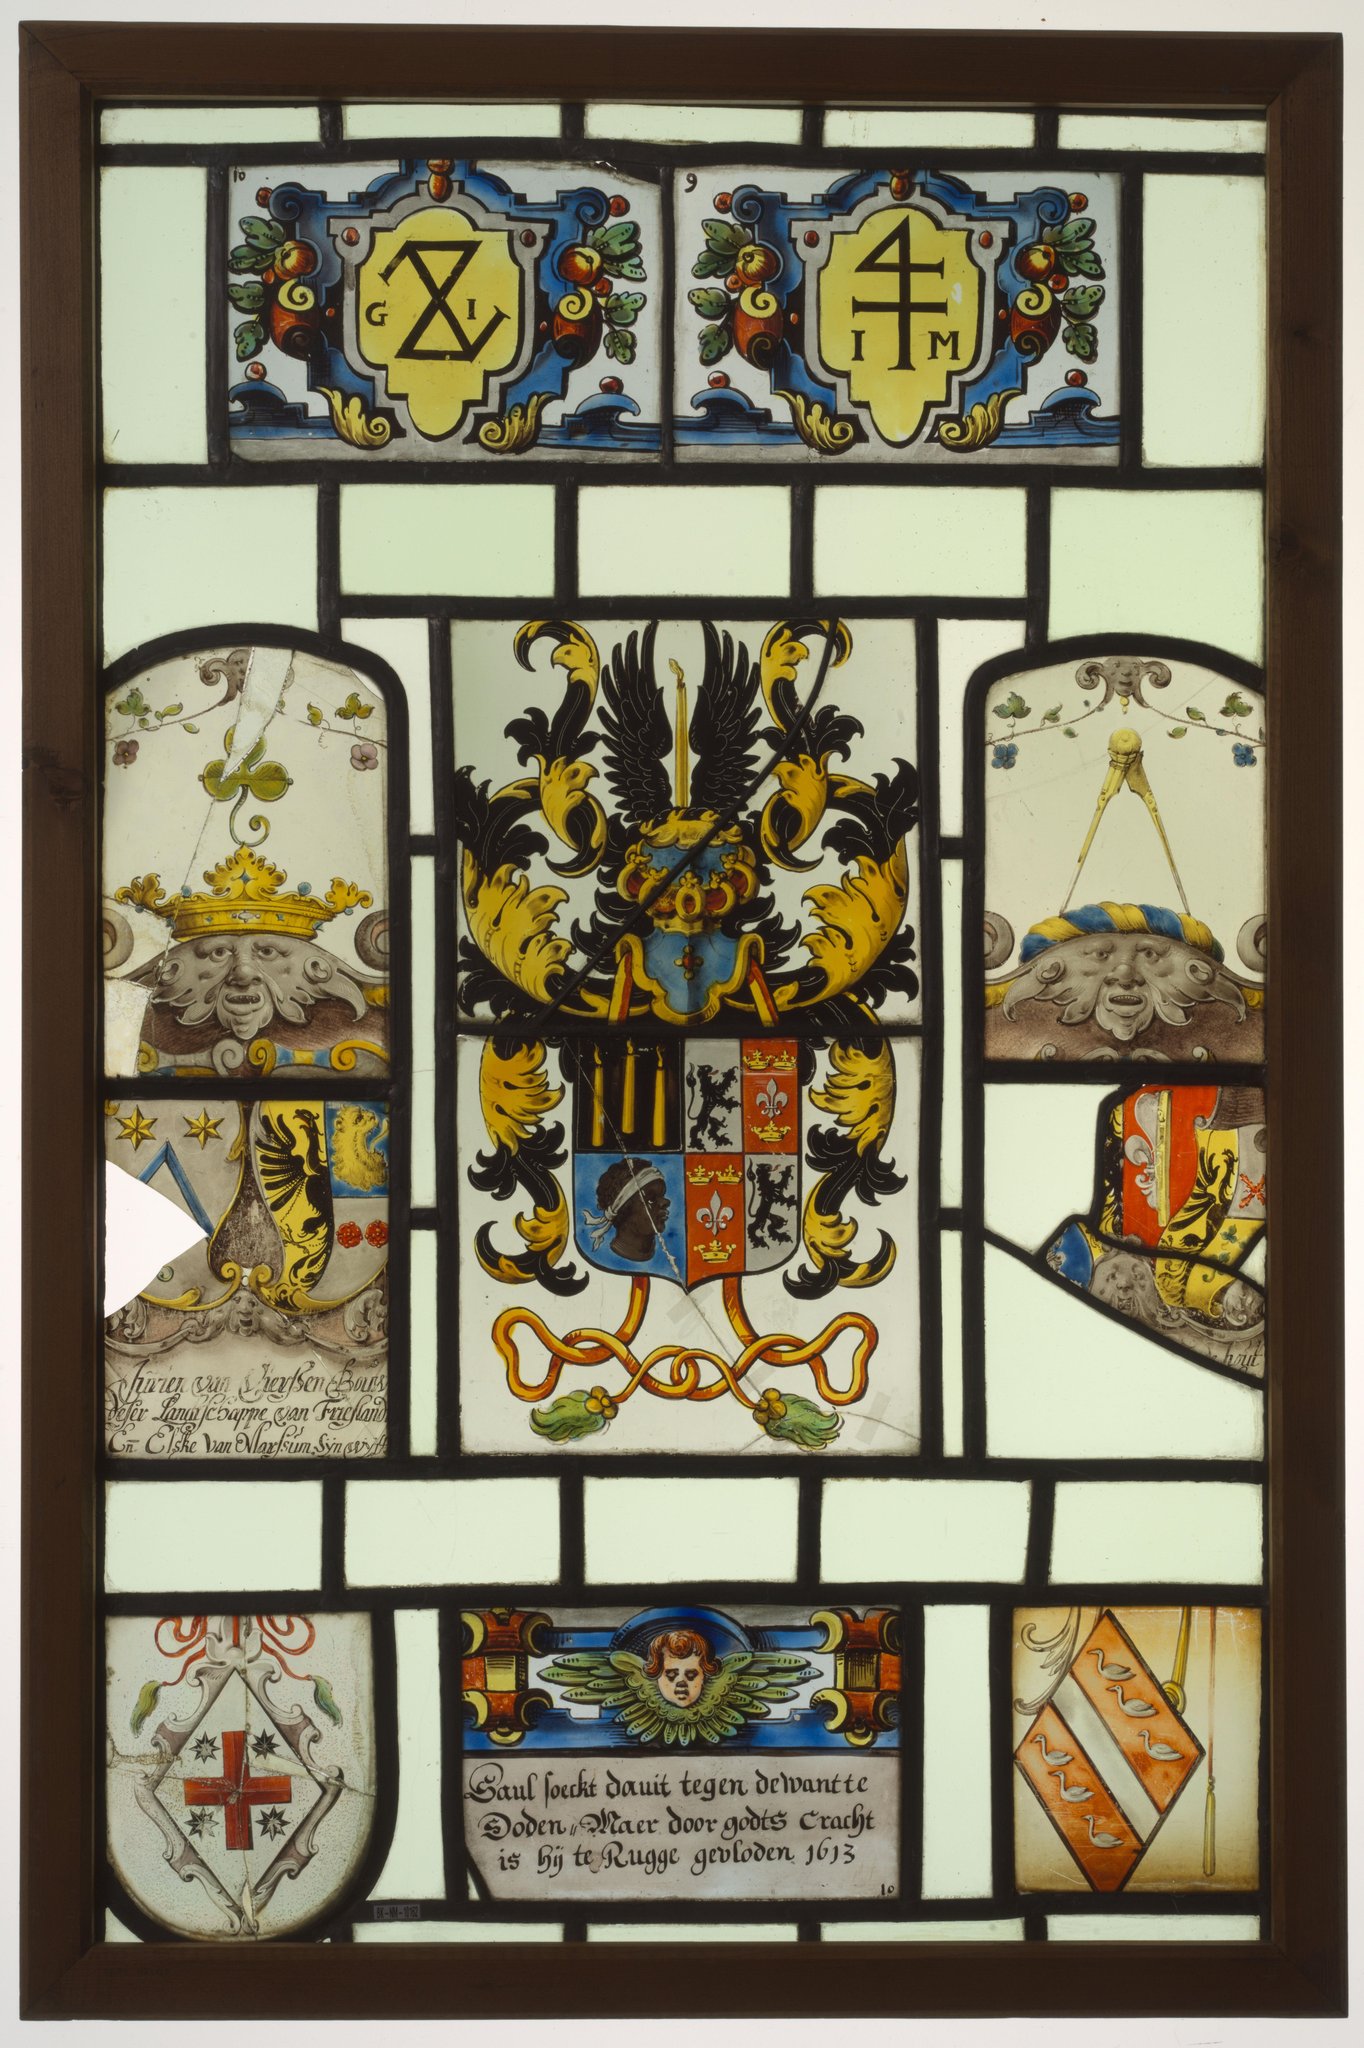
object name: wapenruit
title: Ruit met helmteken, wapens, cartouches en onderschrift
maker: Anonymous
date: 1613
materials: glass, lead, pigment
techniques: leading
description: Ruit met helmteken, wapens, cartouches en onderschrift "Saul soeckt davit tegen de want te Doden Maer door godts Vracht is hij te Rugge gevloden 1613". In het midden een compleet wapen met een gevierendeeld wapenschild. In één kwart drie brandende kaarsen en in een ander een kop van een moor.